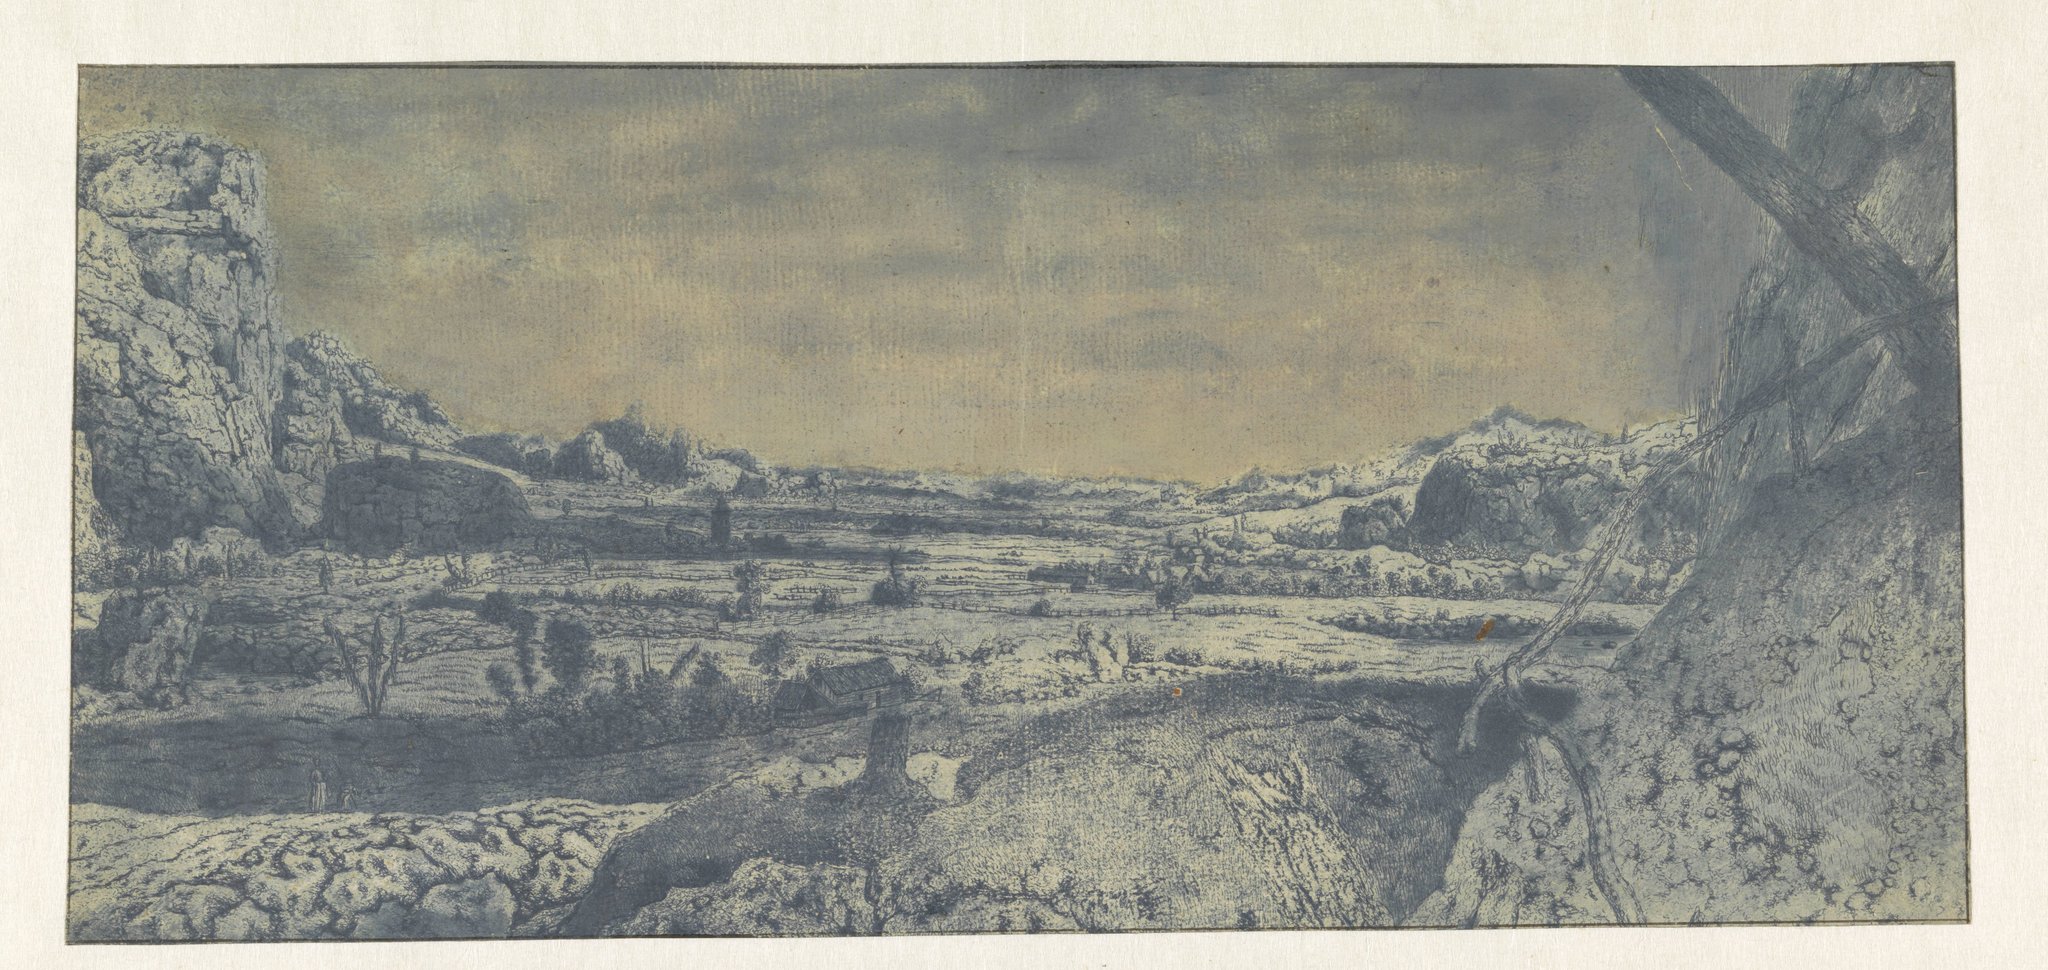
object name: print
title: Mountain Valley with Fenced Fields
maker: hercules segers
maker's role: draughtsman, painter, print maker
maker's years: 1589-1640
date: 1625-1630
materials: oil, paper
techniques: brush, drypoint, etching, hand coloring, intaglio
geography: amsterdam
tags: low hill country, balustrade, farm or solitary house in landscape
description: Heuvelig landschap met omheinde velden, rechts een houten balustrade.